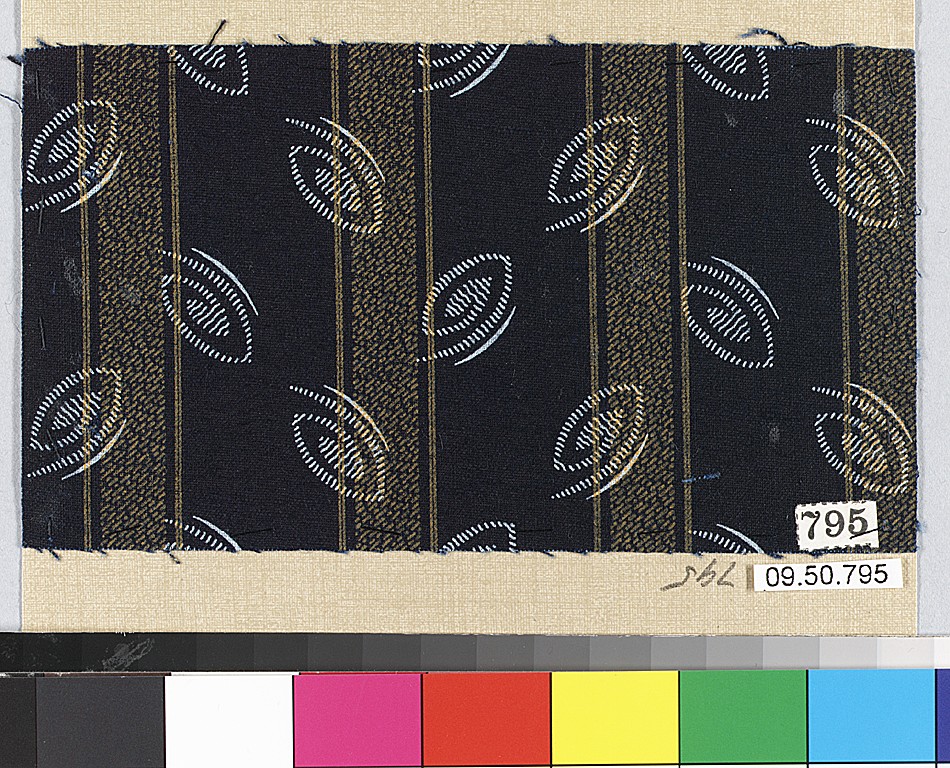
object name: piece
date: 1801-1900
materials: cotton